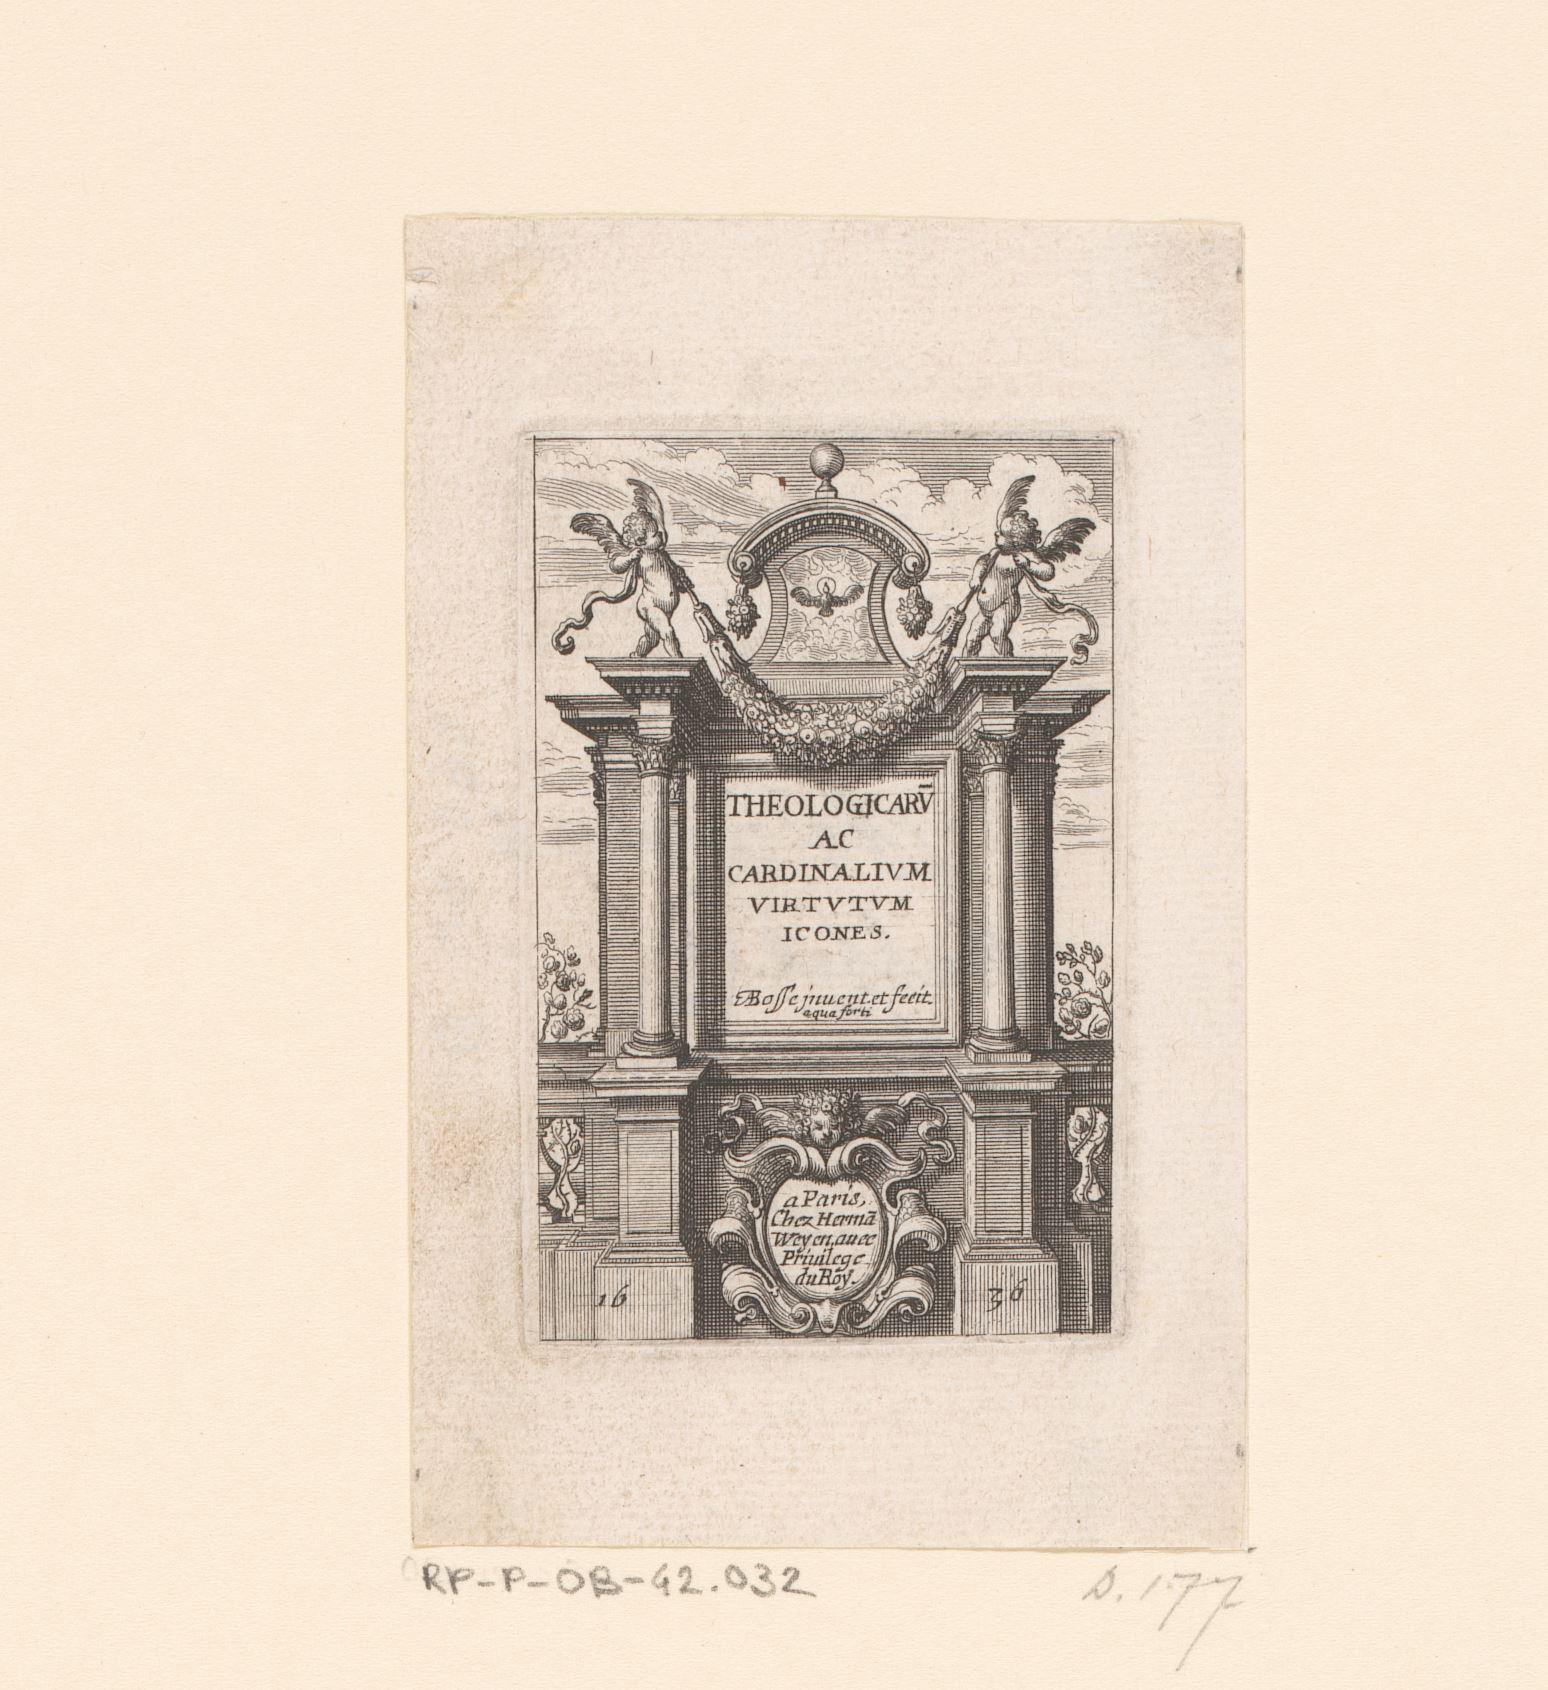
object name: print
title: Titelprent met architecturale omlijsting en putti met een guirlande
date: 1636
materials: paper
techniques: engraving, etching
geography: paris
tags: architectural representations in general, ornament ~ festoon, garland, cupids: 'amores', 'amoretti', 'putti'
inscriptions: inscription: ‘1886 Janss/ dubbel/ Holman’, collector's mark: Lugt 2228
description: Titelprent voor een serie van negen prenten (inclusief een titelprent met opdracht en een tweede titelprent) met personificaties van de zeven deugden.